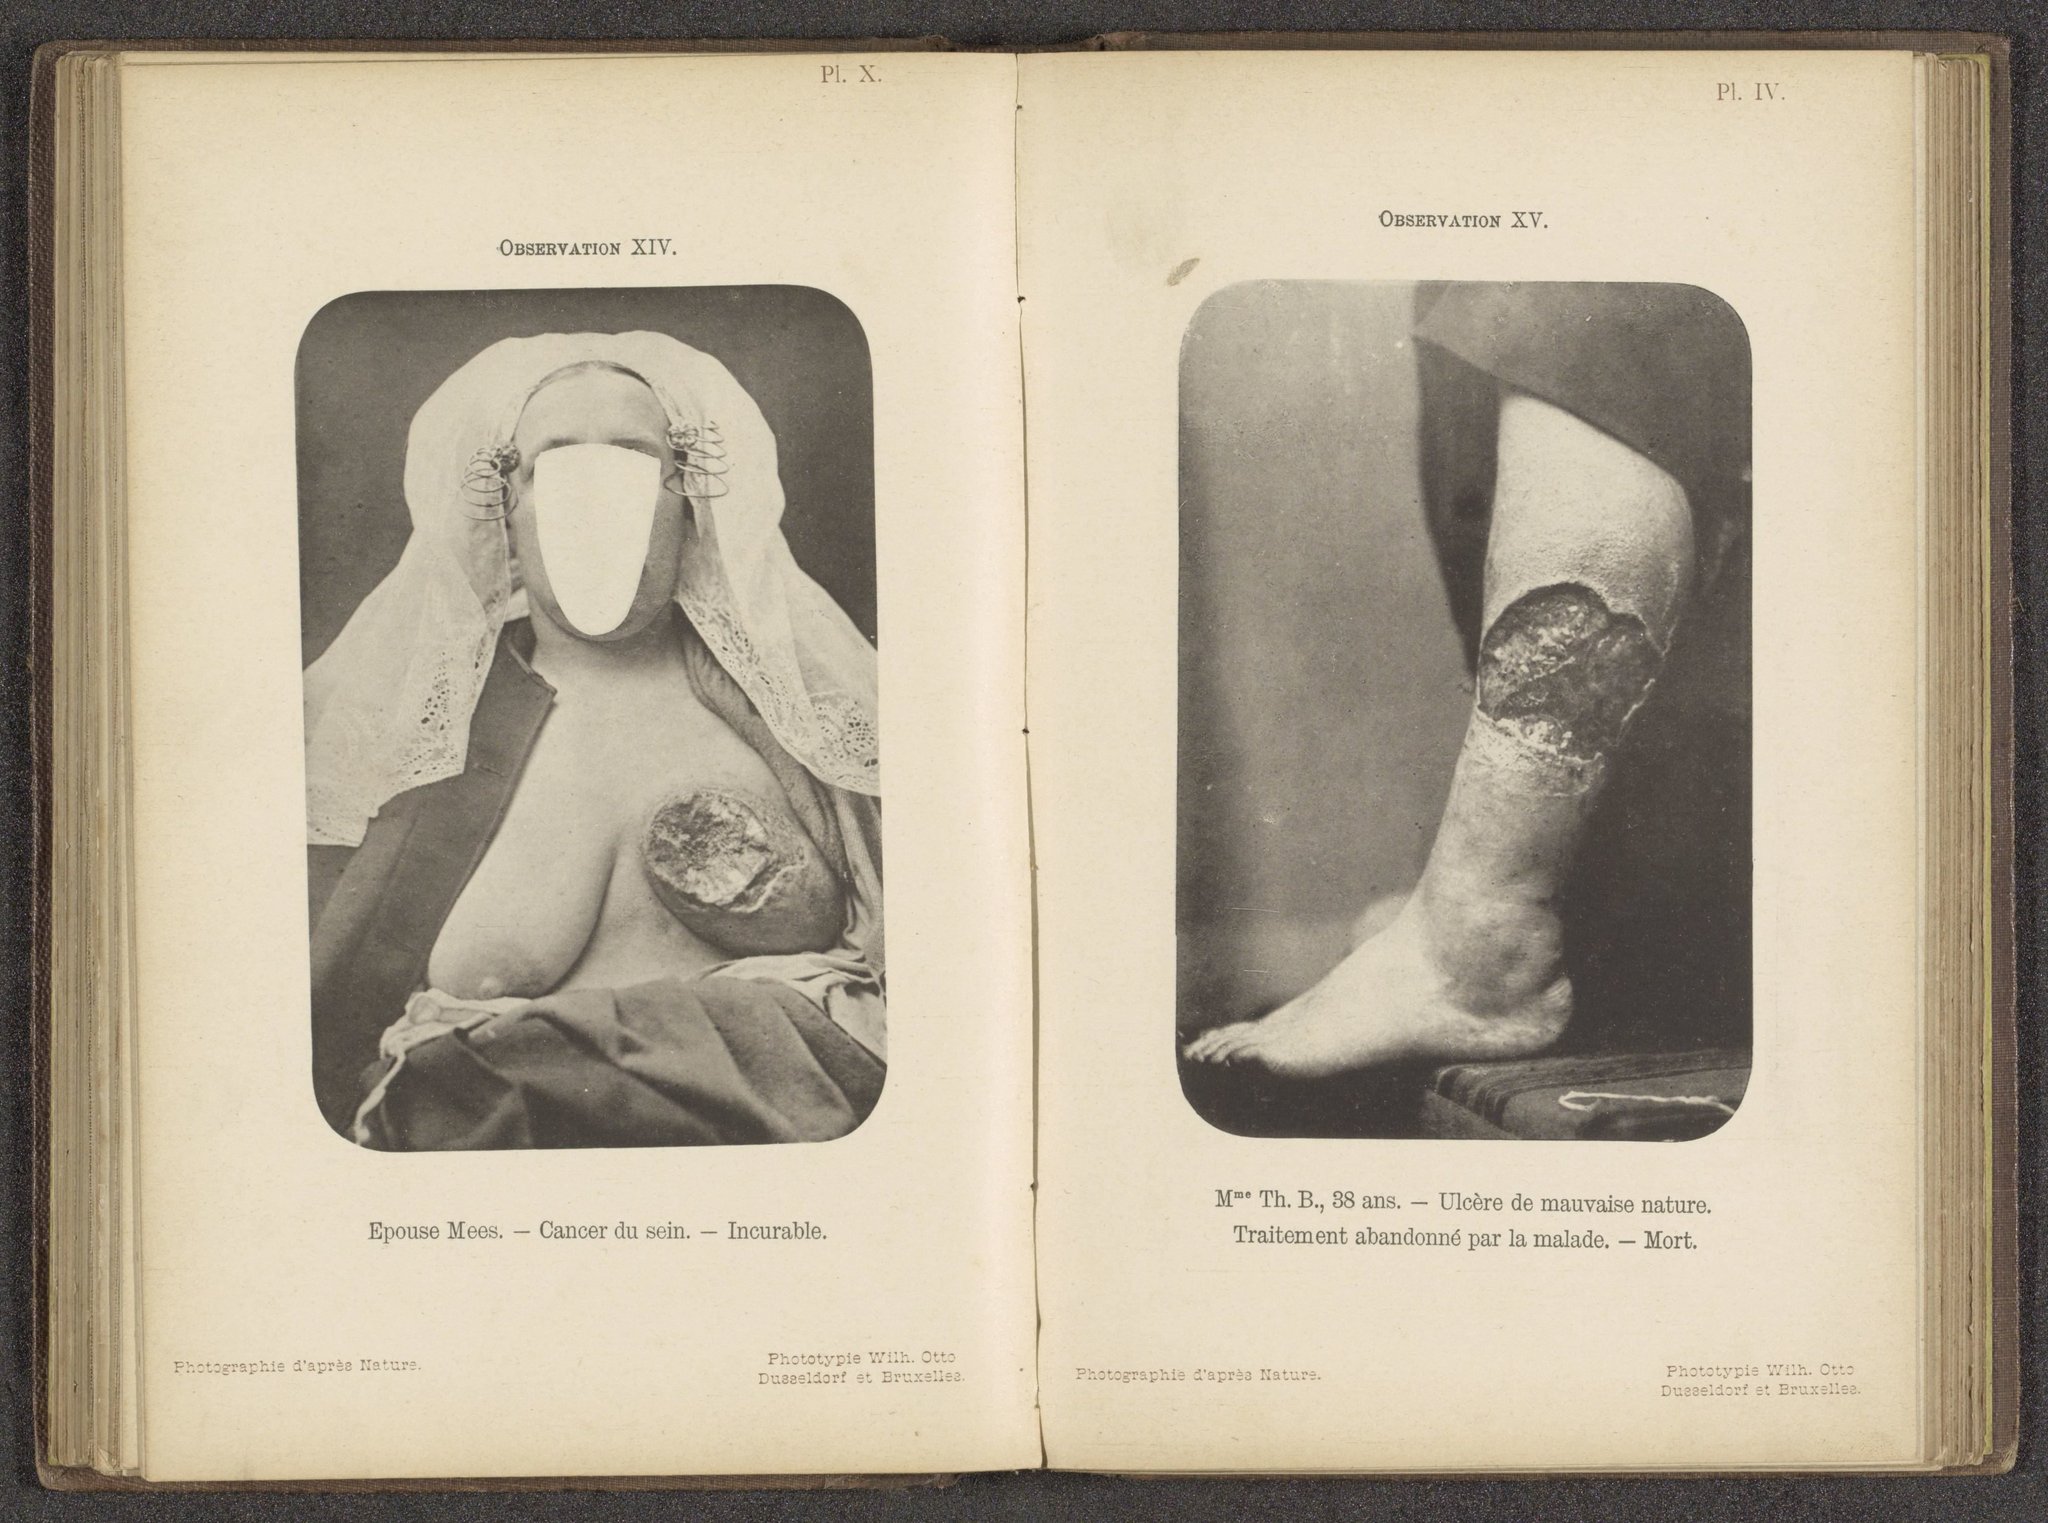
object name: photomechanical print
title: Zwerende wond op een onderbeen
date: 1874-1884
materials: paper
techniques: photograph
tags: tumours - aa - female human figure, infections and wounds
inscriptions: inscription: ‘Pl. IV. / Observation XV. / Mme Th. B.., 38 ans. - Ulcère de mauvaise nature. Traitement abandonné par la malade. - Mort.’